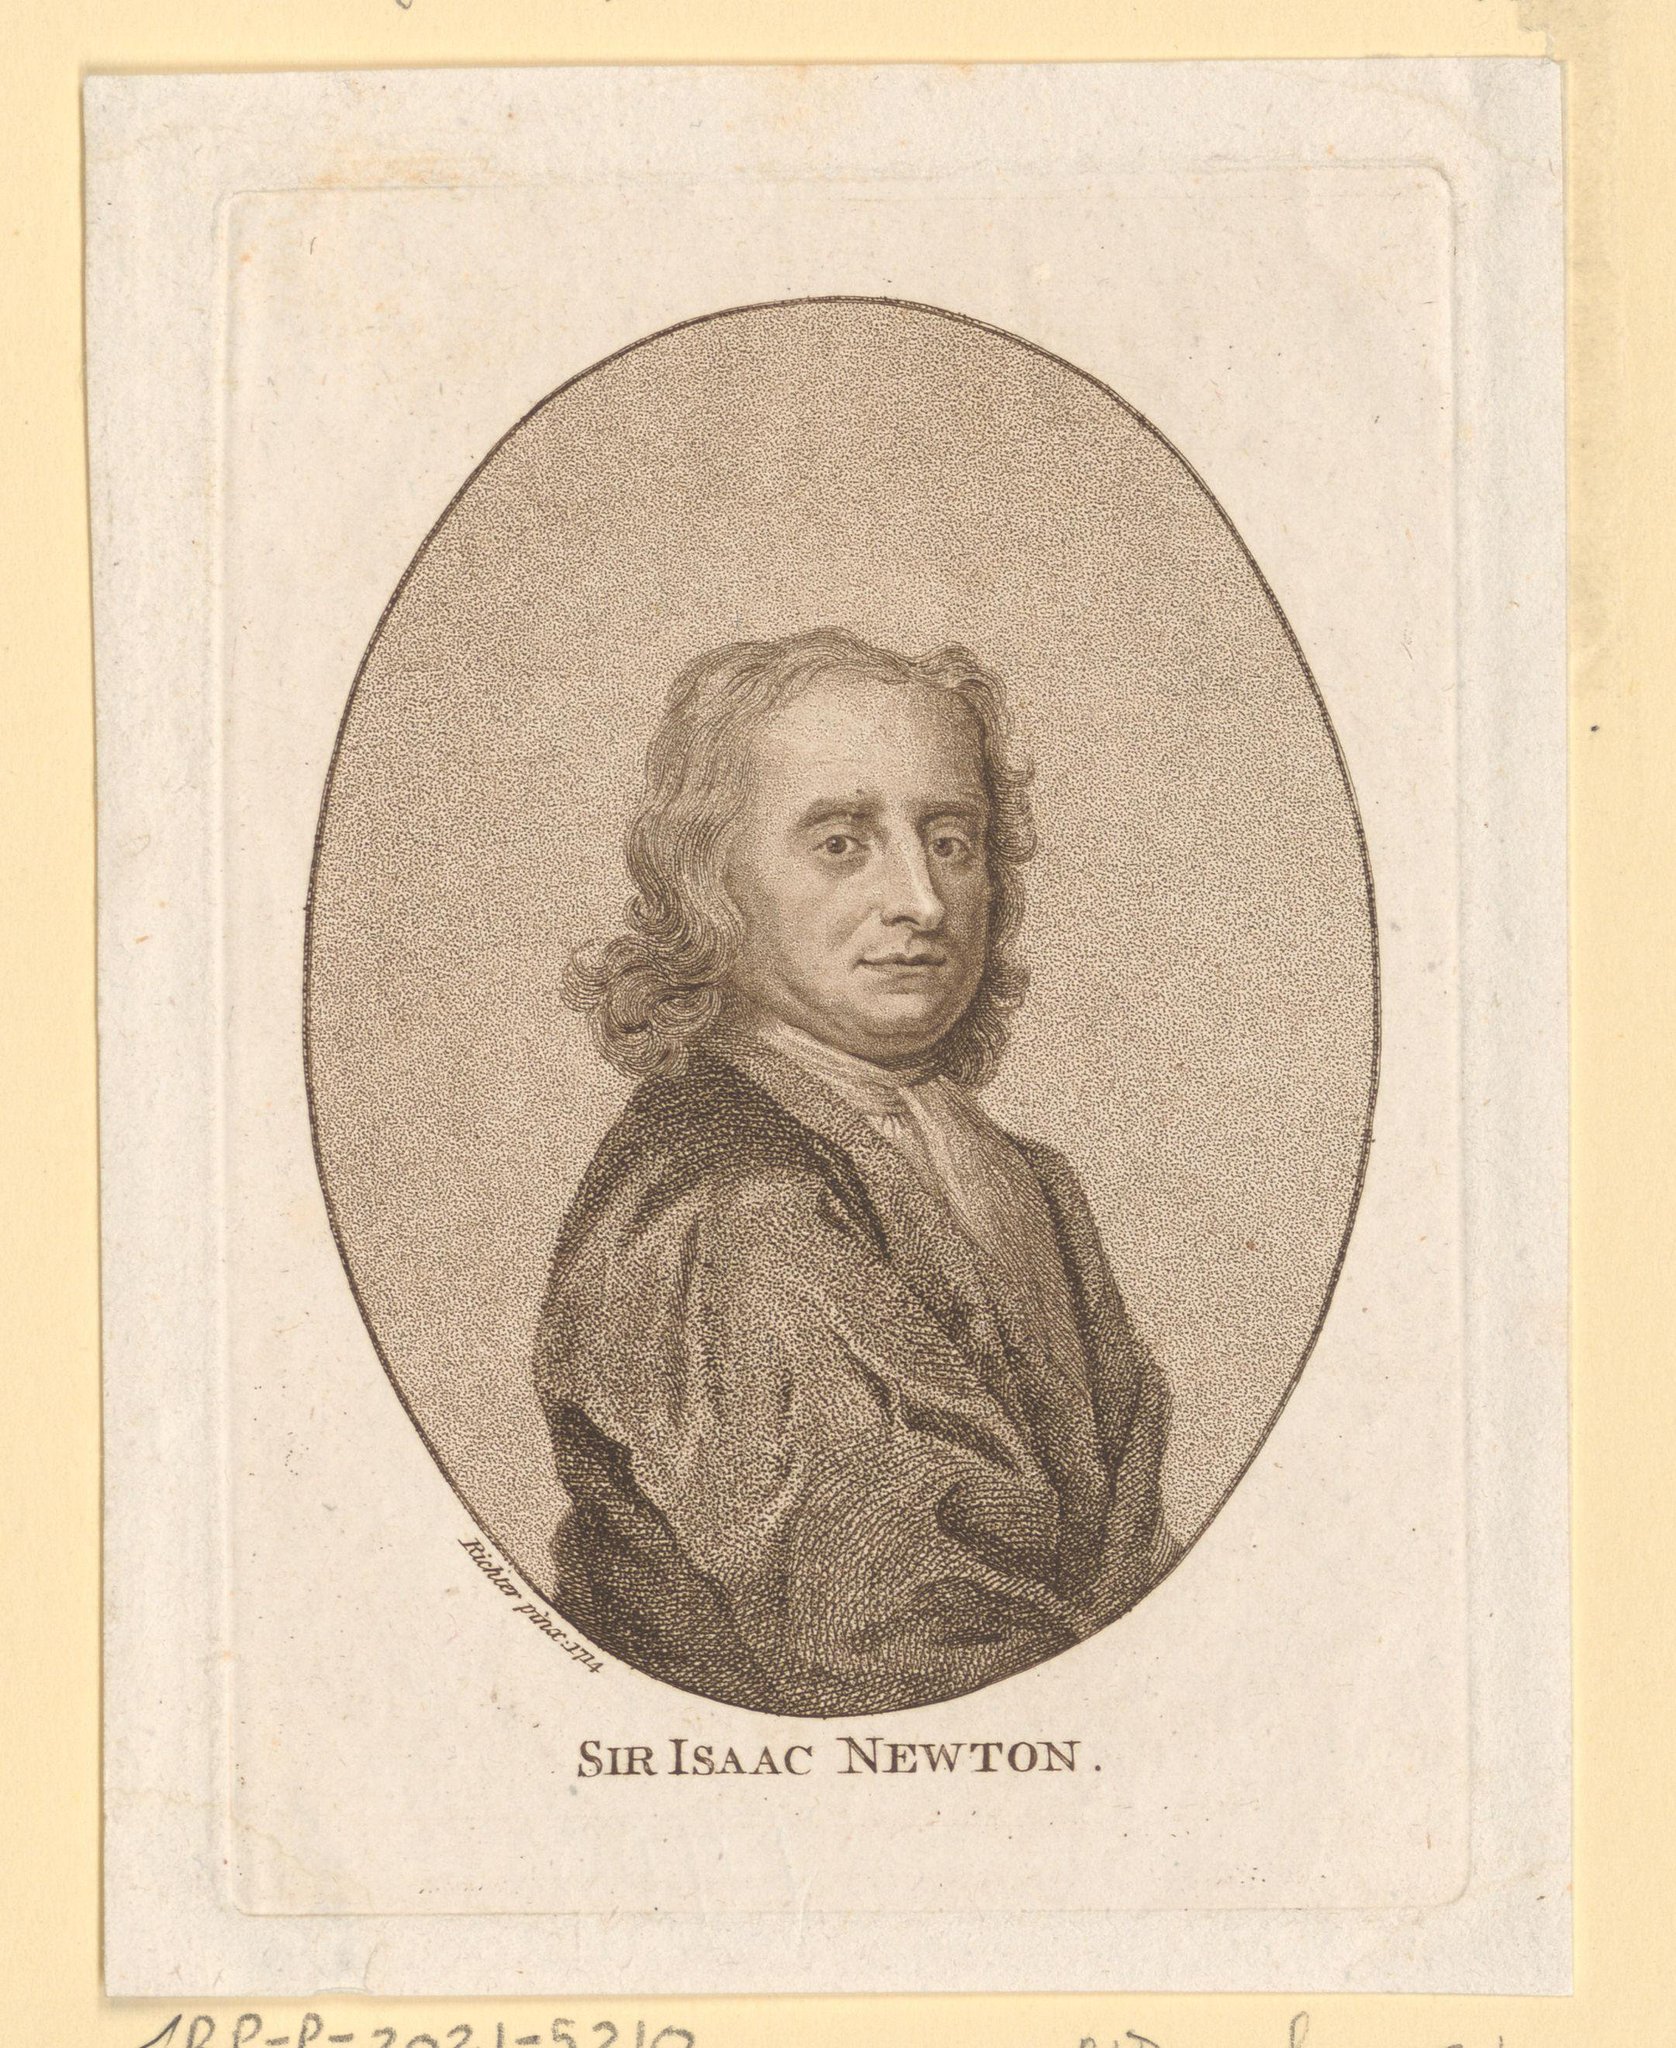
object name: print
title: Portret van Isaac Newton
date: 1814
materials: paper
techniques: engraving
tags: physicist, historical persons, invention, discovery ~ science and technology